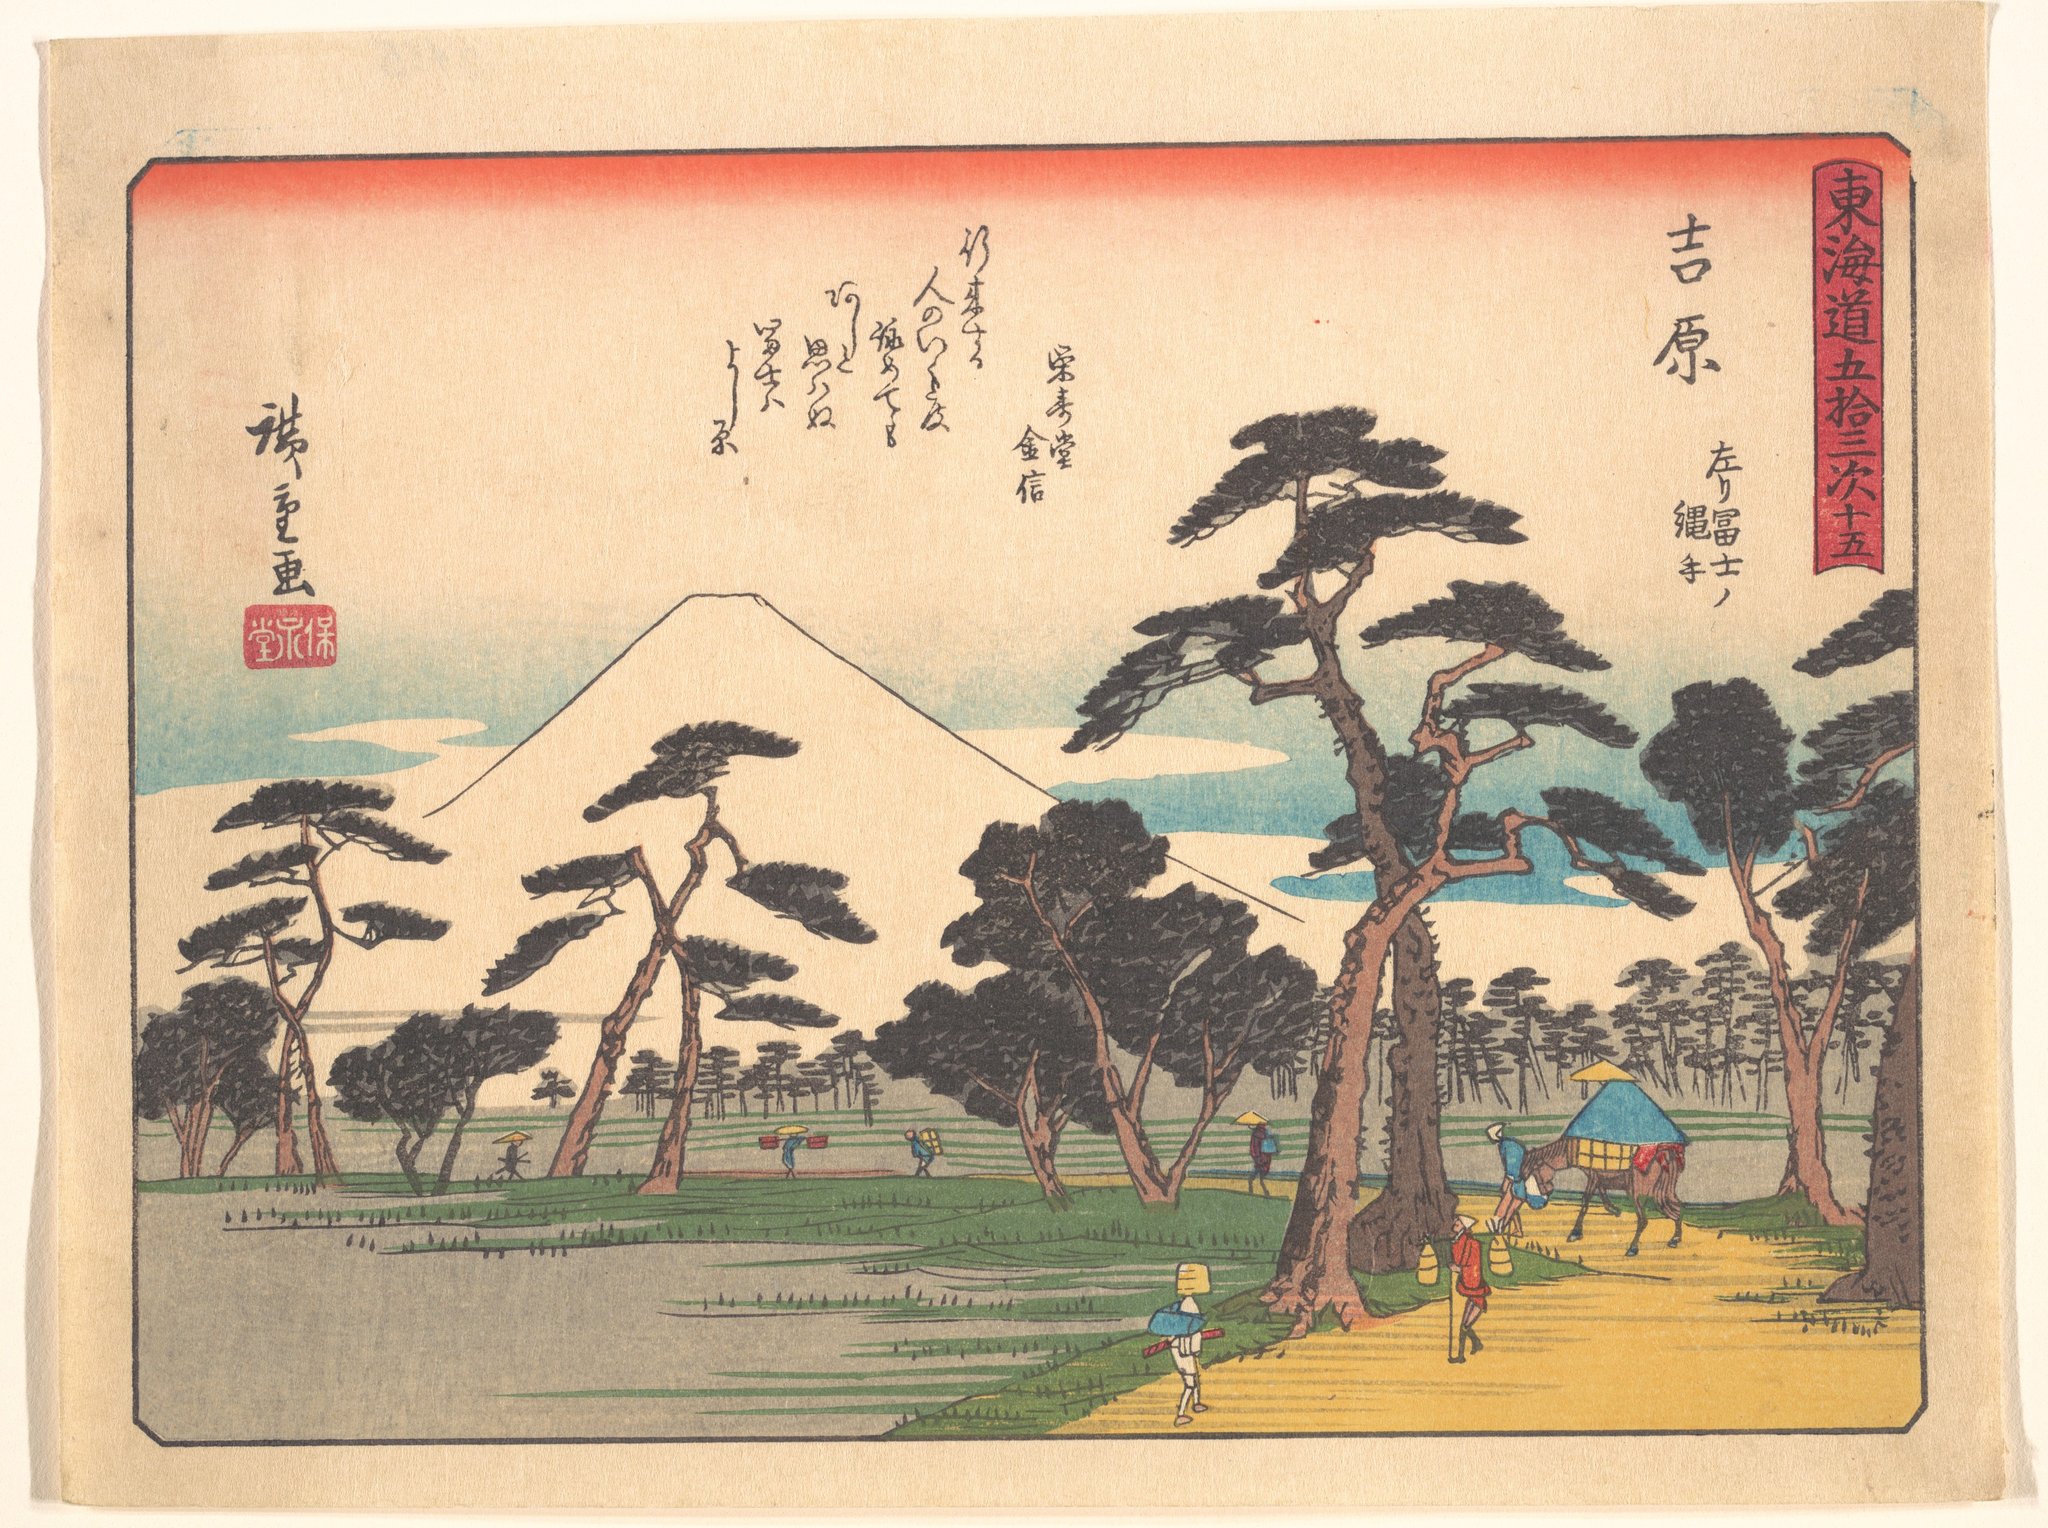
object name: print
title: 東海道五十三次 吉原 左リ富士ノ縄手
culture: japanese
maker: utagawa hiroshige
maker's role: artist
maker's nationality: japanese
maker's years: 1797-1858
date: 1901-1933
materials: ink, paper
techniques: woodblock print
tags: human figures,horses,mountains,trees